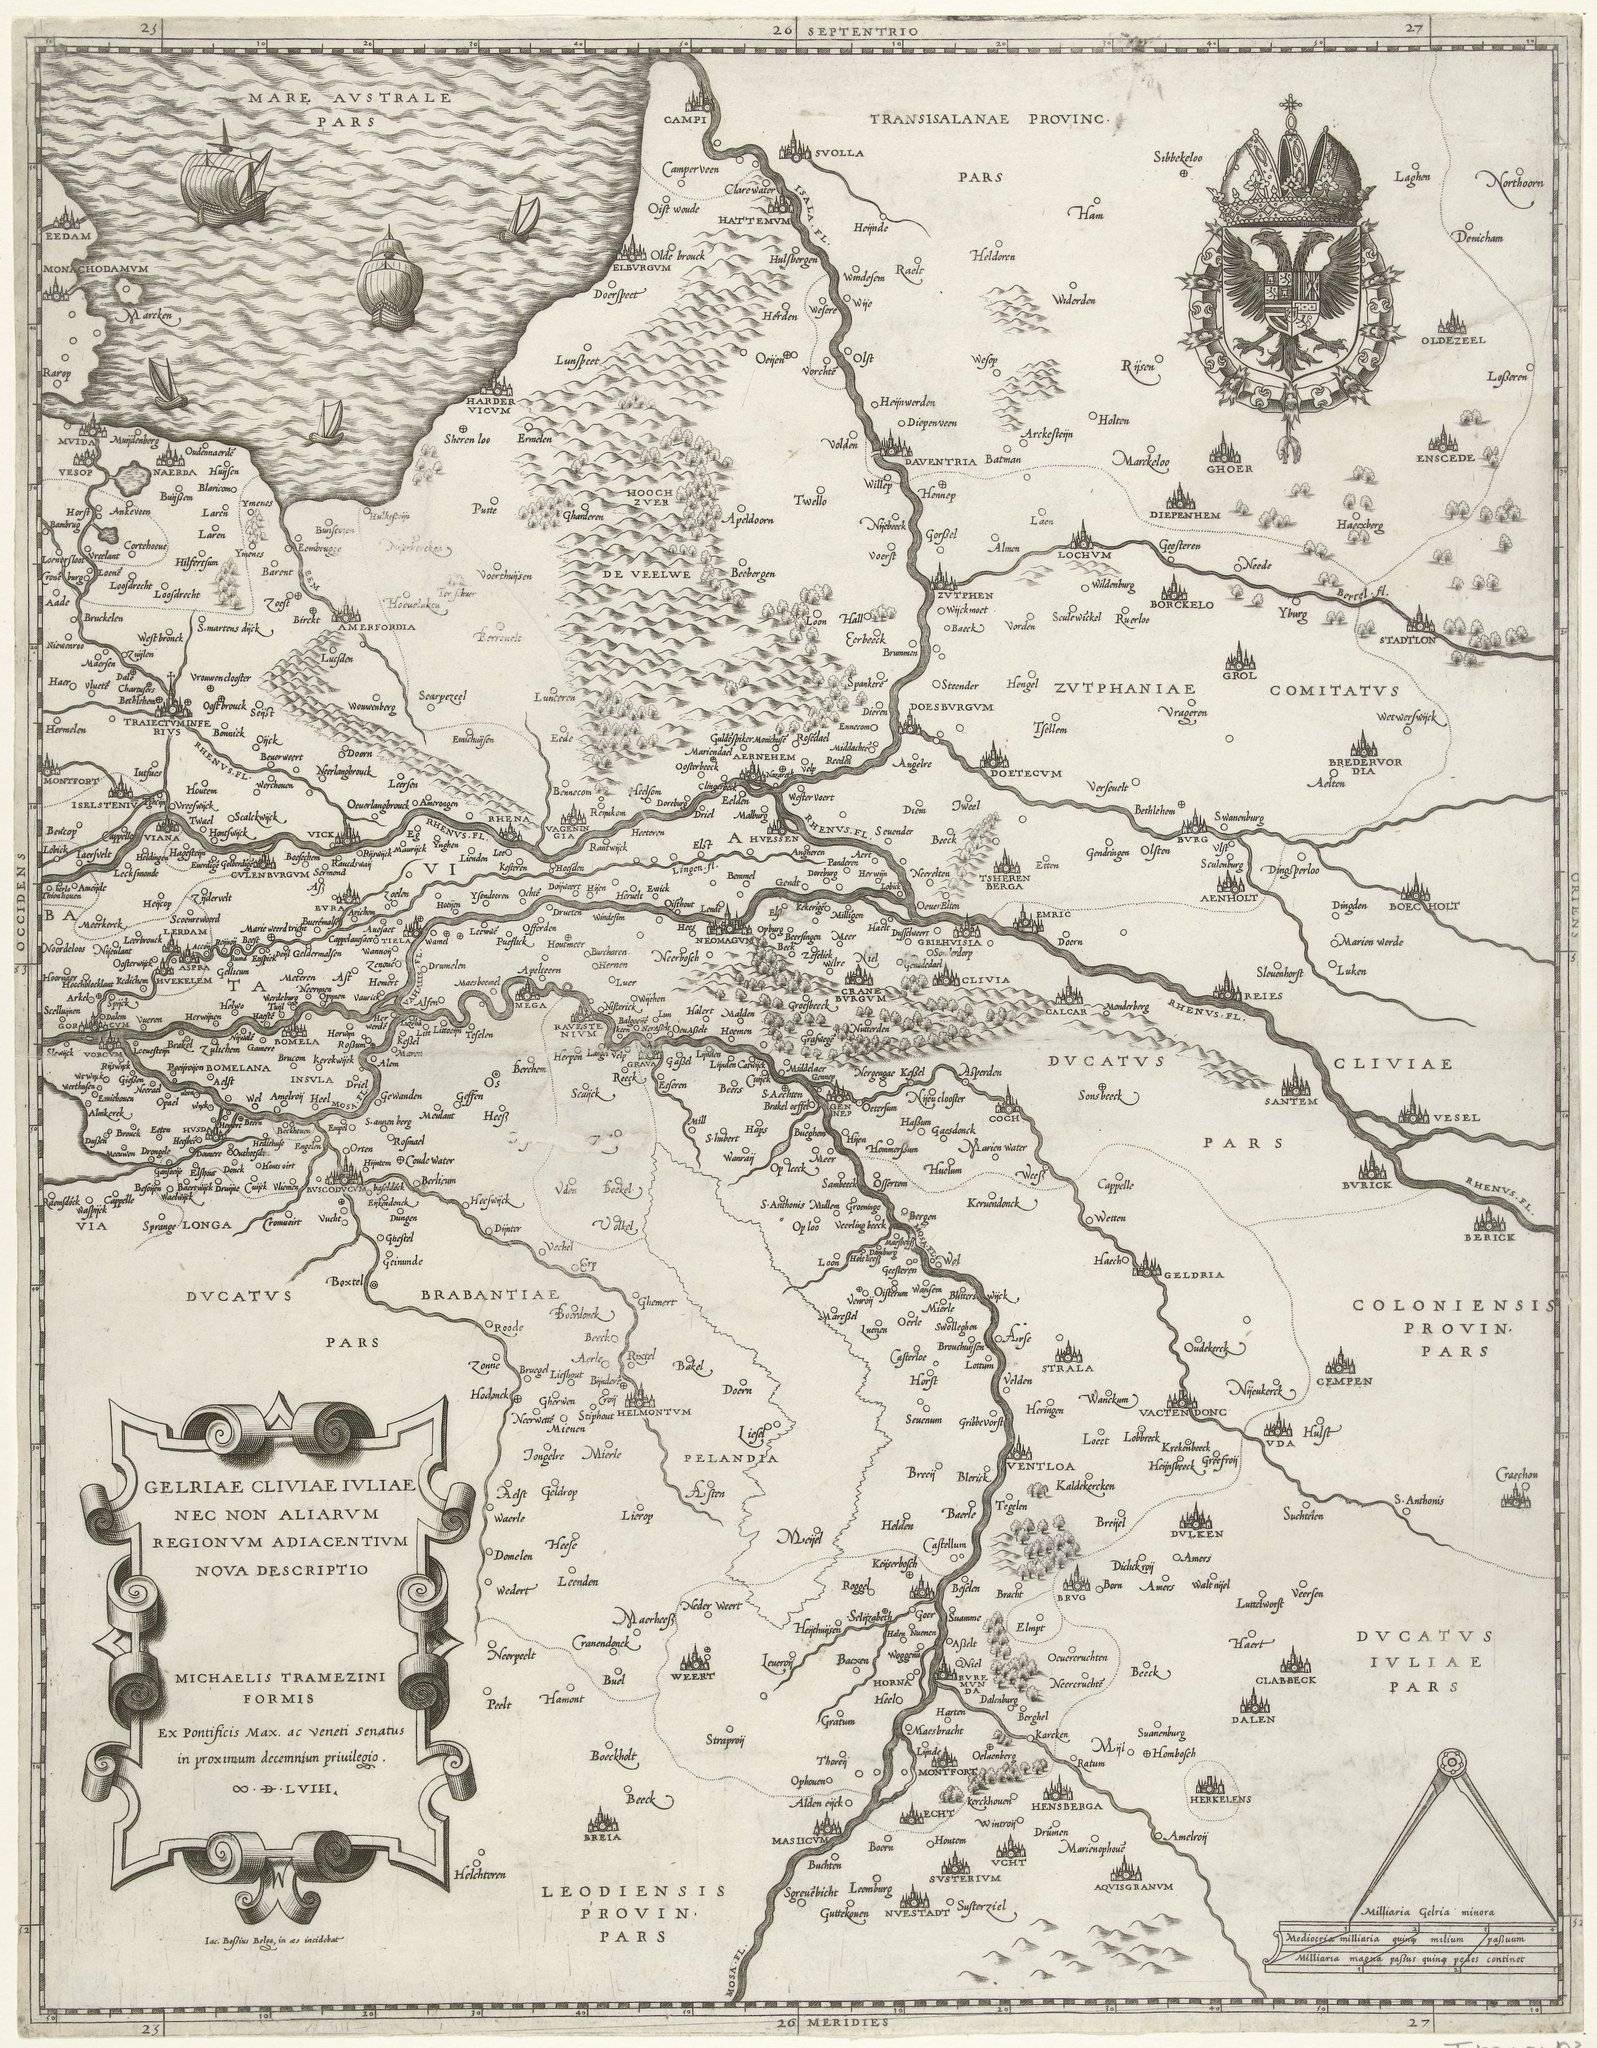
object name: map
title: Gelriae cliviae iuliae nec non aliarum regionum adiacentium nova descriptio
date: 1568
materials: paper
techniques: engraving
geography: italy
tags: maps of separate countries or regions, cleves, gelderland, guelders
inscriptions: date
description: Kaart van Gelderland, Kleef en deel van Limburg. Linksonder een cartouche met de titel, rechtsonder de passer met schalen. Rechtsboven het keizerlijk wapen met het Gulden Vlies. Alle opschriften in het Latijn.